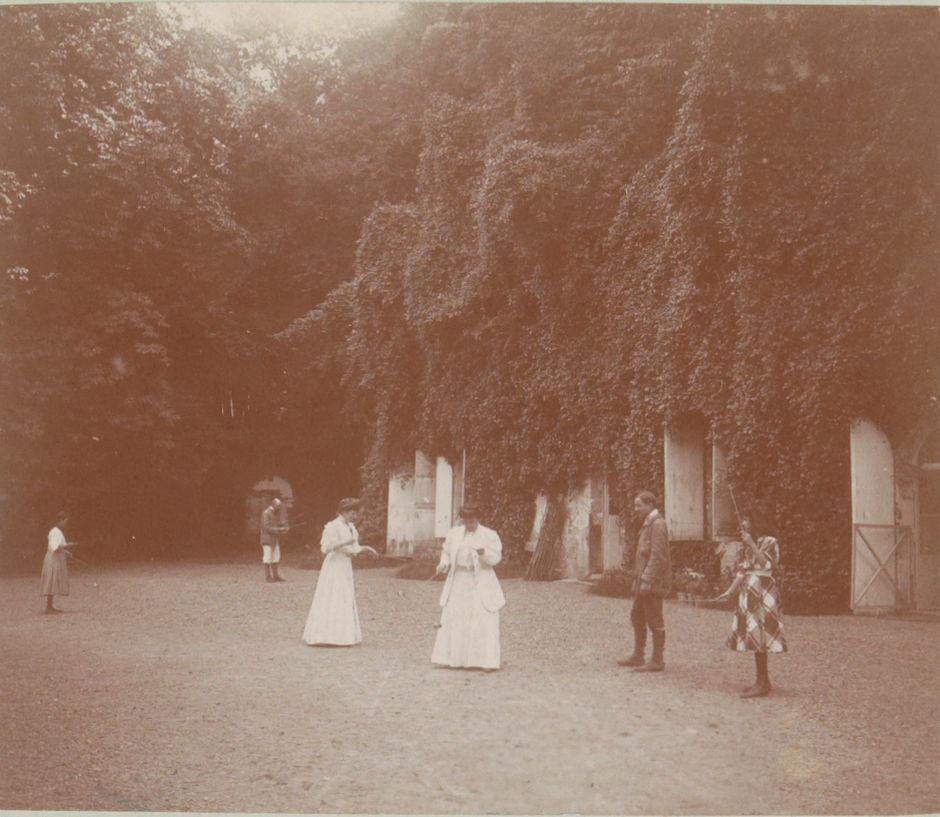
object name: photograph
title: Groep mannen en vrouwen spelend met diabolo's, vermoedelijk in Italië of Frankrijk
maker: Anonymous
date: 1905-1910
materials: paper, photographic support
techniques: gelatin silver print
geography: europe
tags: illusionist, conjurer, juggler, 'legerdemain', europe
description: Onderdeel van Fotoalbum van een Franse amateurfotograaf met bezienswaardigheden in Frankrijk, Zwitserland en Italië.